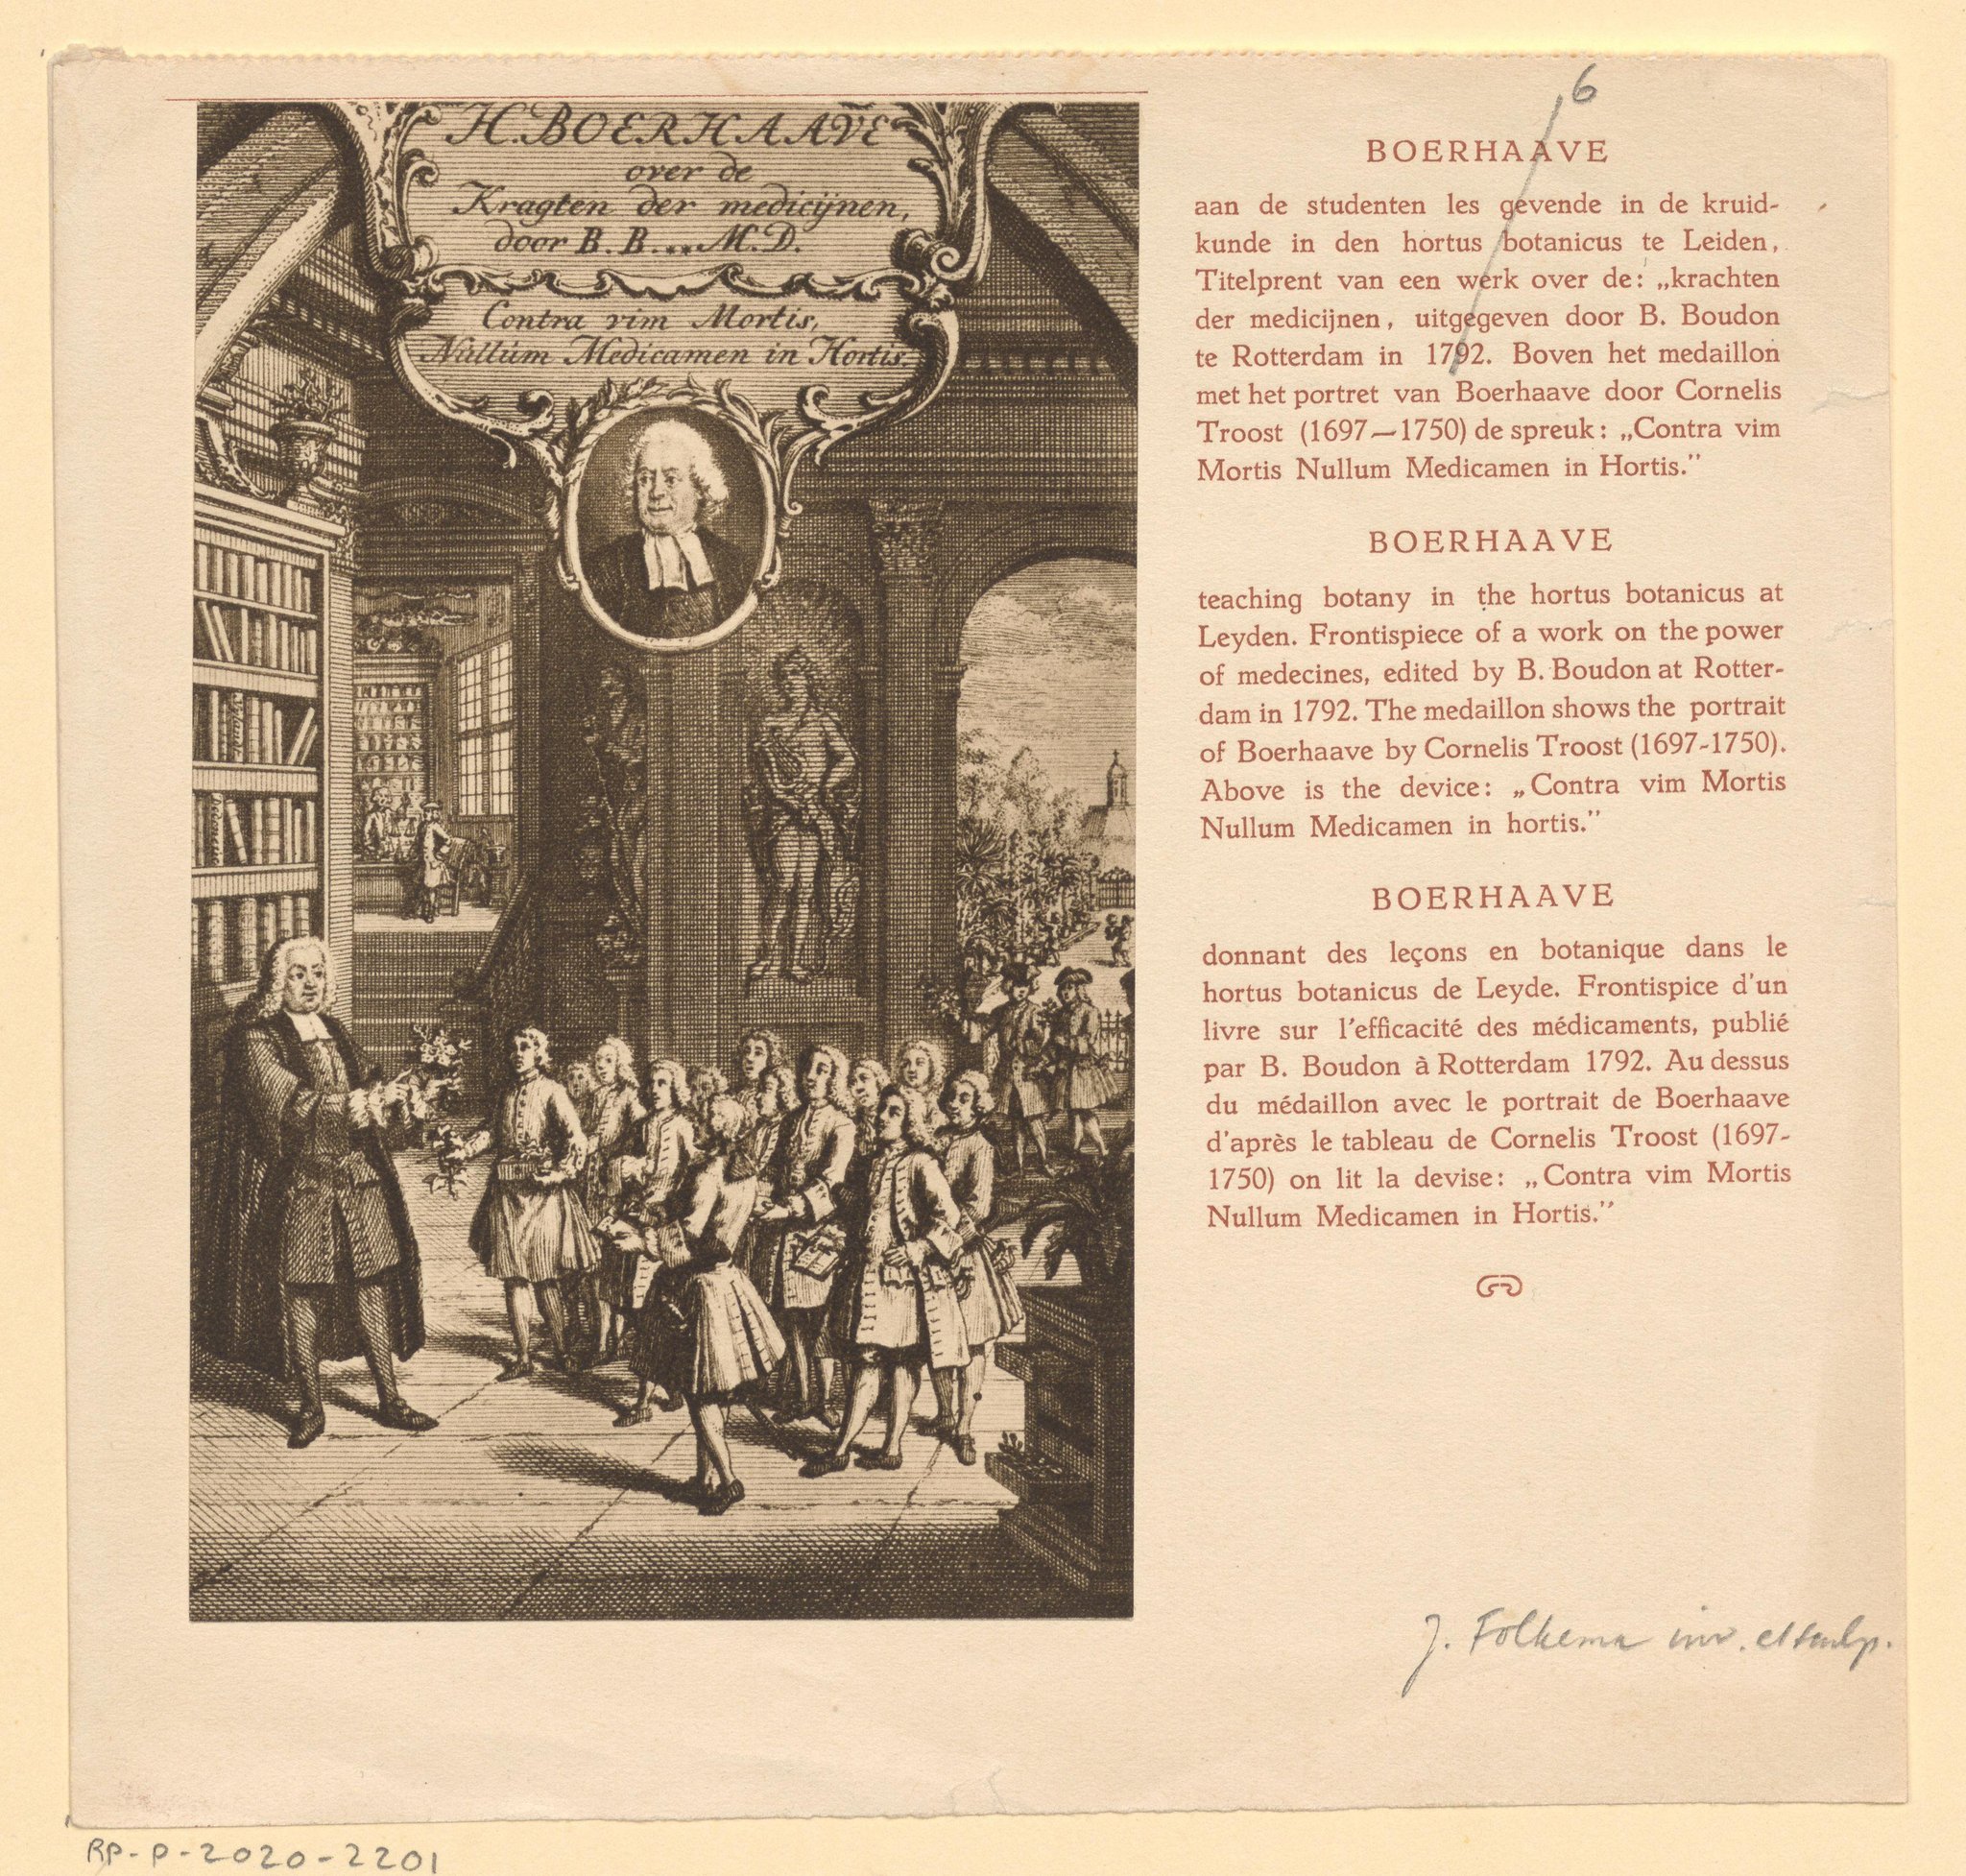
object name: photomechanical print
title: Titelpagina voor: H. Boerhaave, Verhandeling over de kragten der medicijnen, 1756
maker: Anonymous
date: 1900-1930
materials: paper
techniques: photograph, letterpress printing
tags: leiden, hermanus boerhaave, historical persons, professor, botanic garden, 'hortus botanicus', education